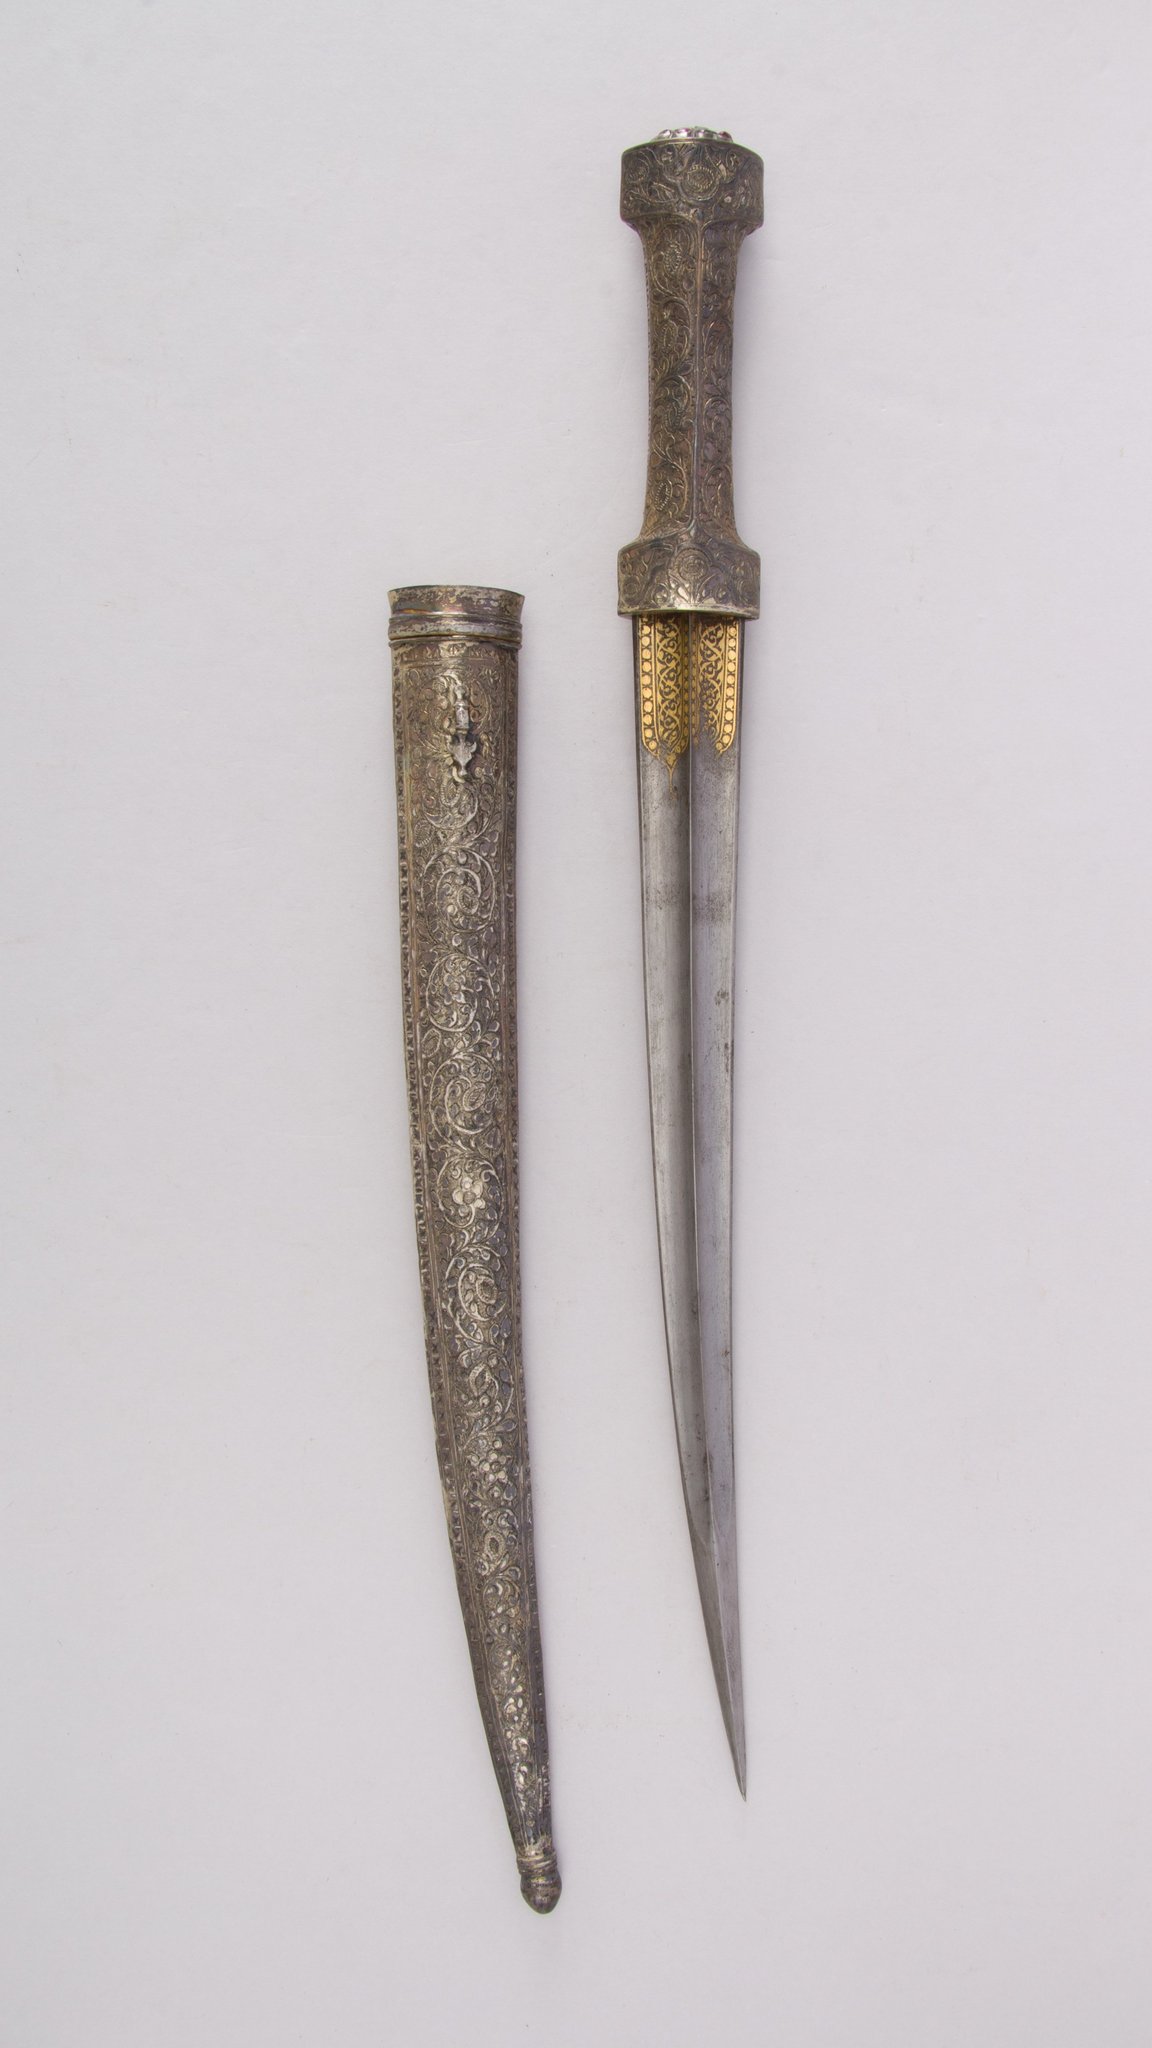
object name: dagger with sheath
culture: turkish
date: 1801-1900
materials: gemstone, silver, steel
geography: turkey